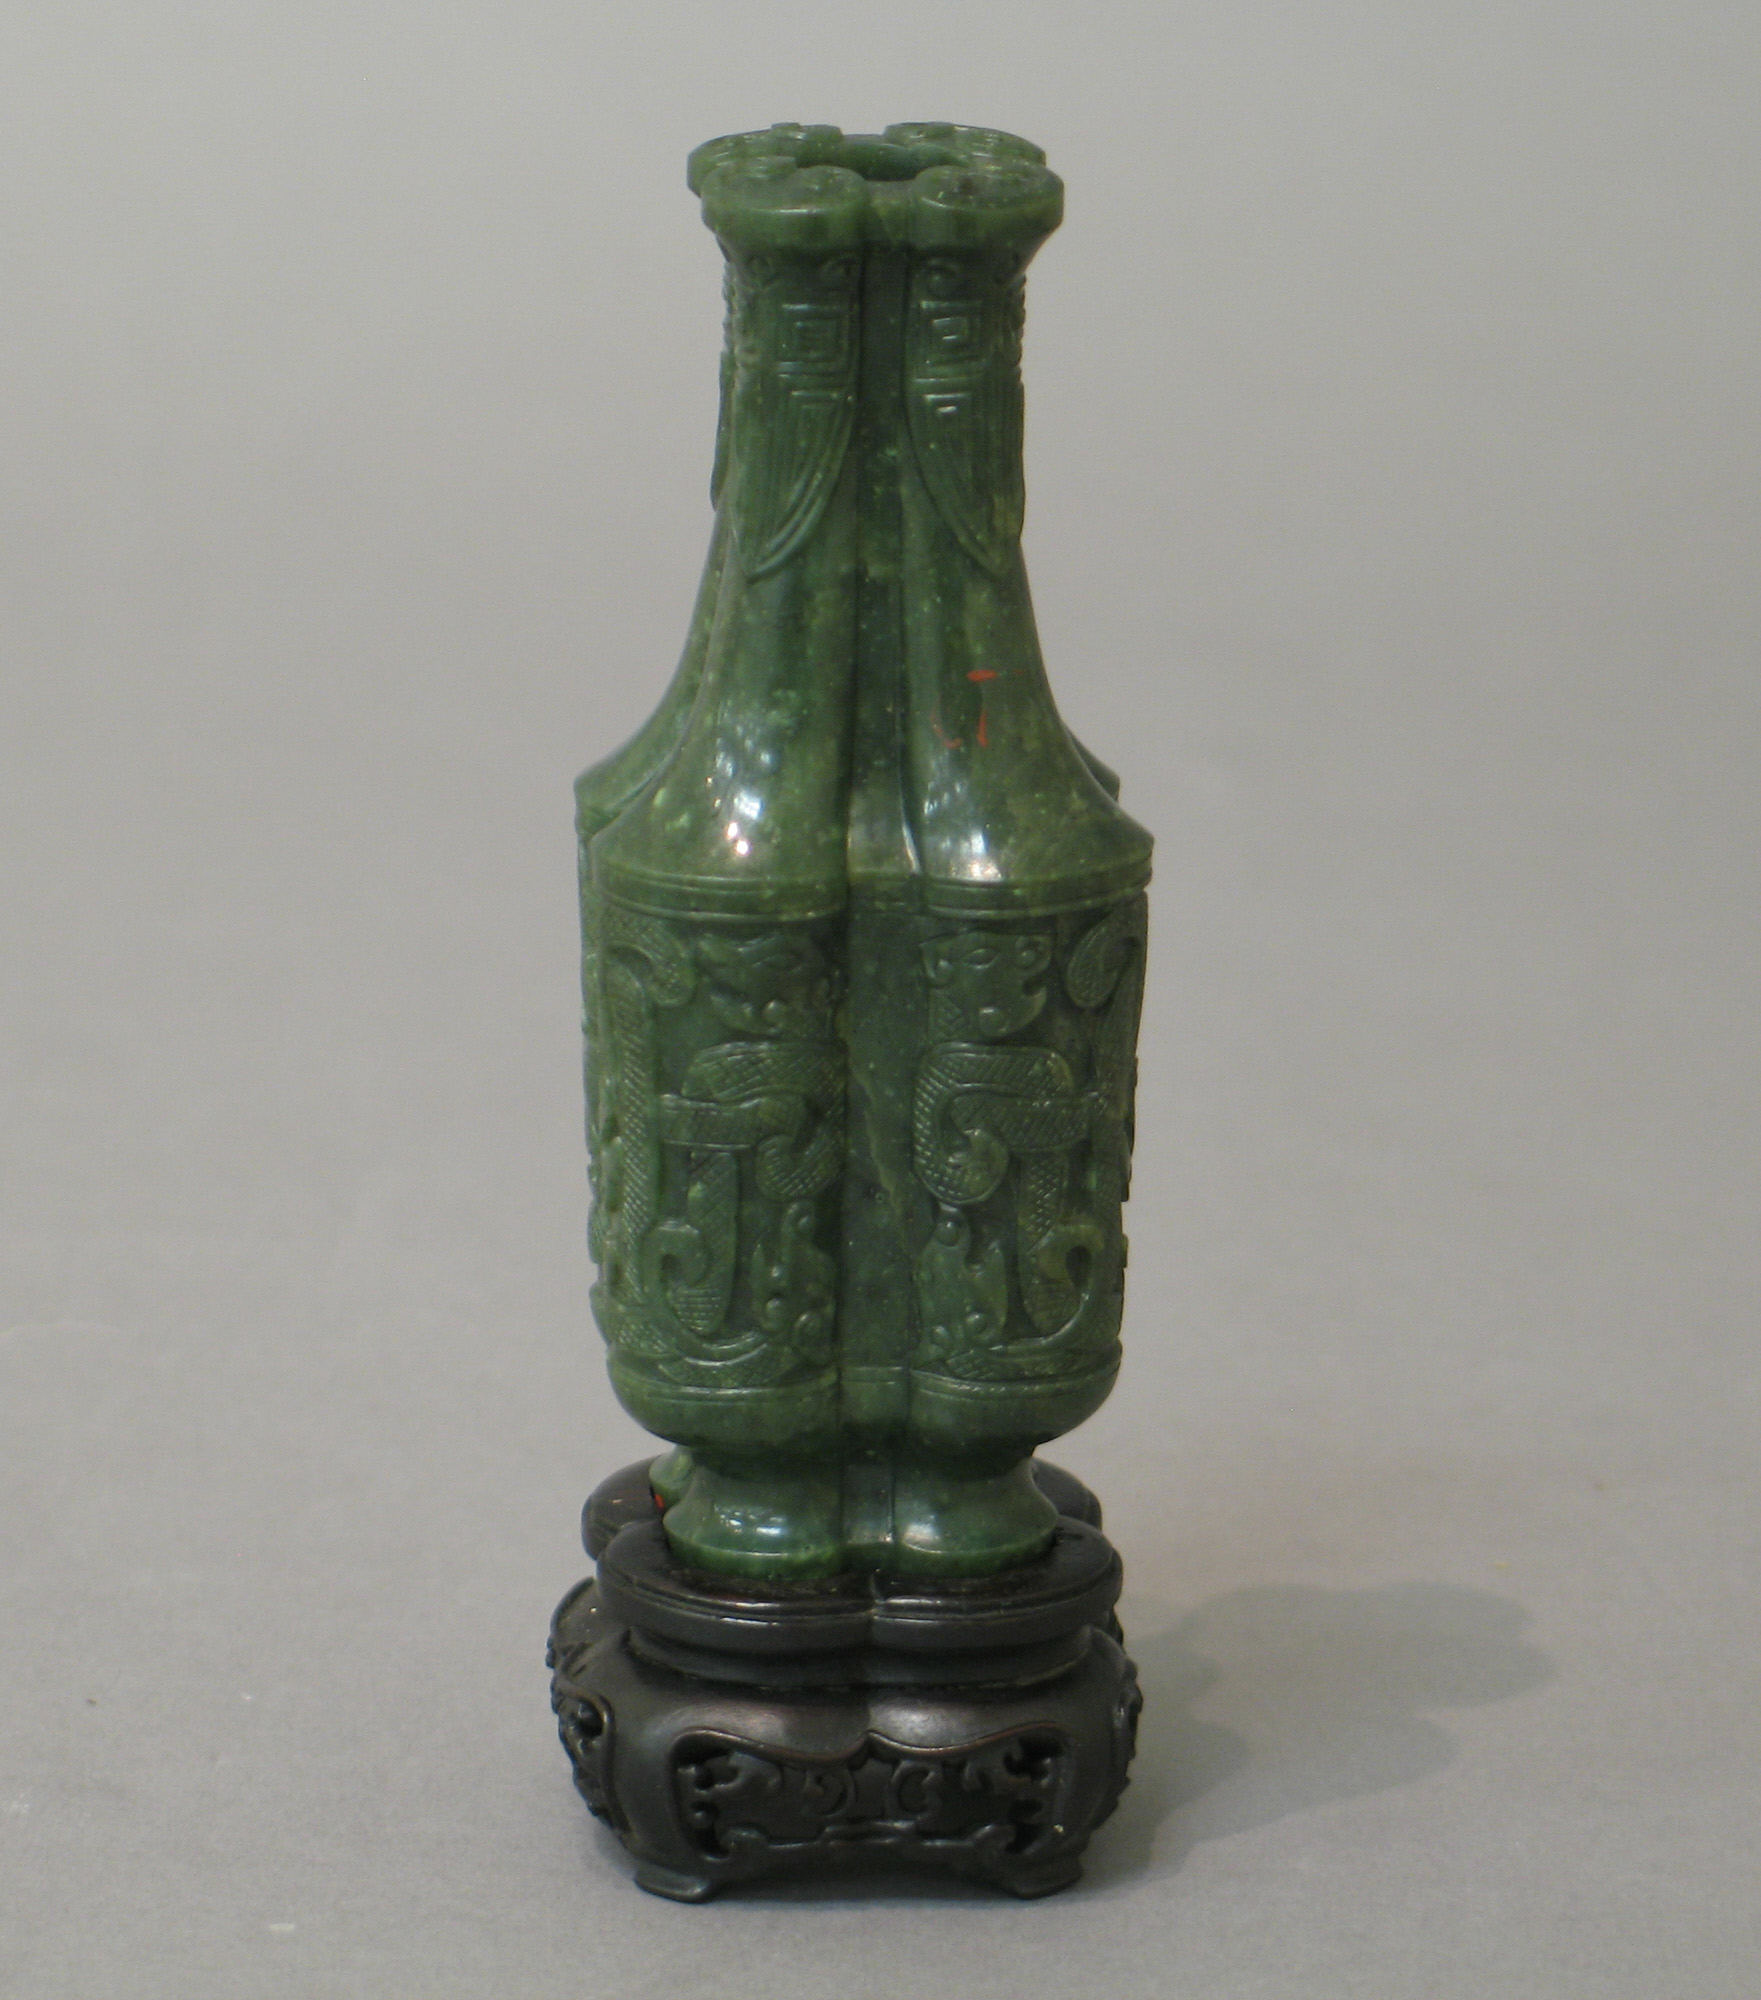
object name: vase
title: Vase with archaic motifs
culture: chinese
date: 1736-1795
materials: jade